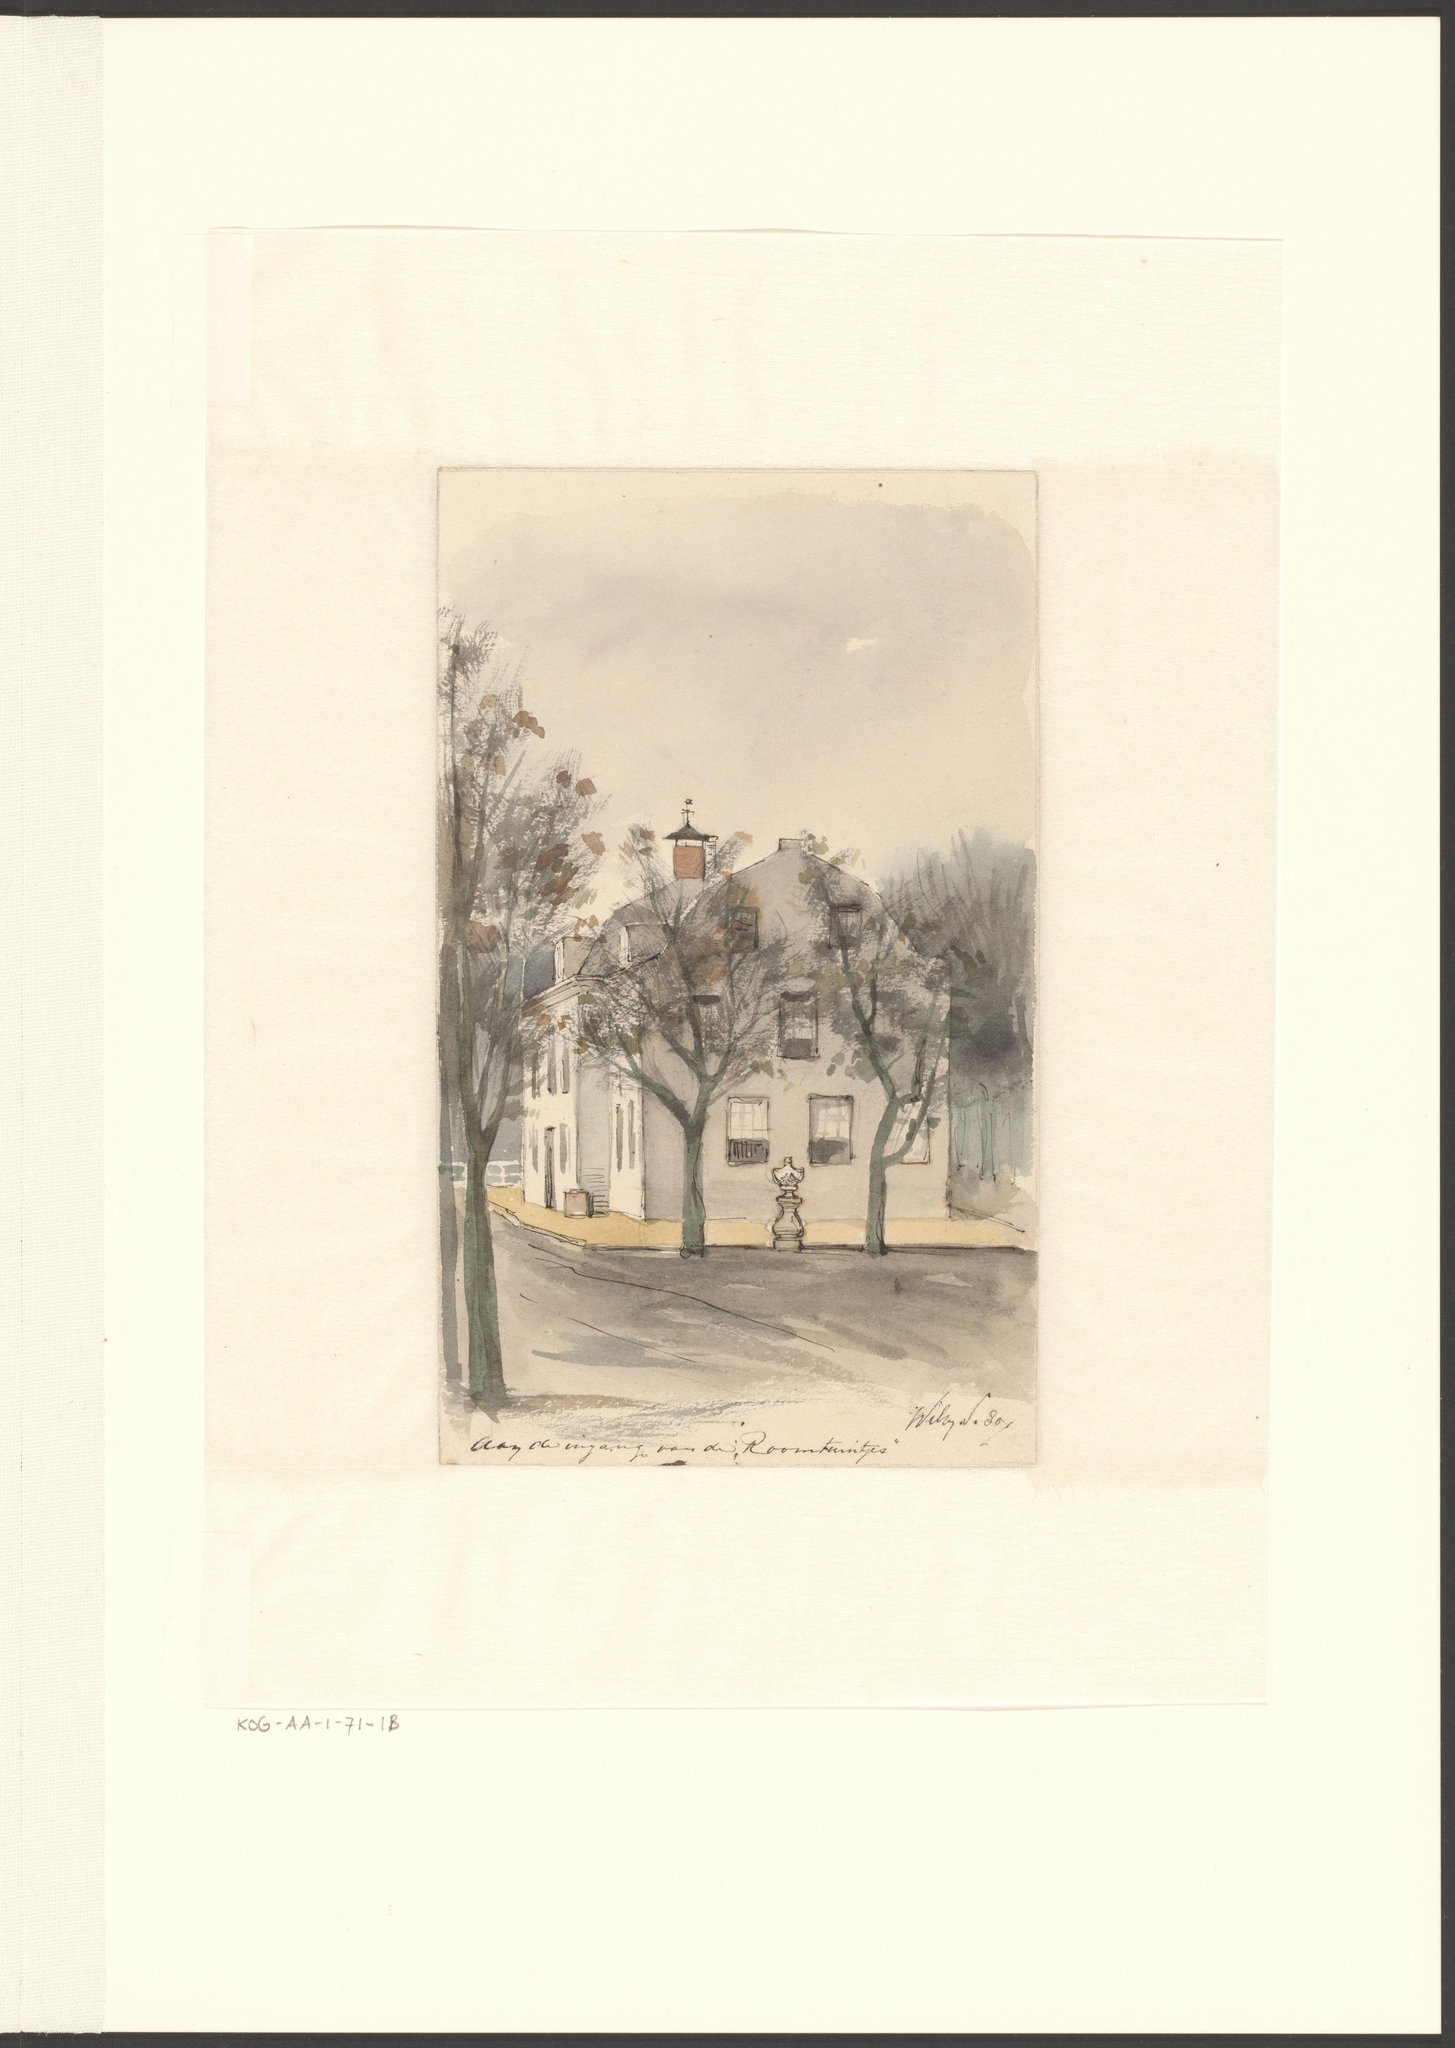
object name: drawing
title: Gezicht op het hoofdgebouw van de uitspanningsplaats bij de ingang van de Roomtuintjes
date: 1880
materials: ink, paper, pencil, watercolor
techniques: brush, pen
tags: city-view in general; 'veduta', canal, tea garden, garden restaurant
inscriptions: signature, date and inscription: ‘Aan de ingang van de Roomtuintjes / Wilm S. 80’, inscription: ‘Het Hoofdgebouw van (...) Kazerne / Oranje Nassau’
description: Onderwerpsrubriek binnen de Atlas Amsterdam: Uitspanningslokalen, ontwerp Vauxhall.